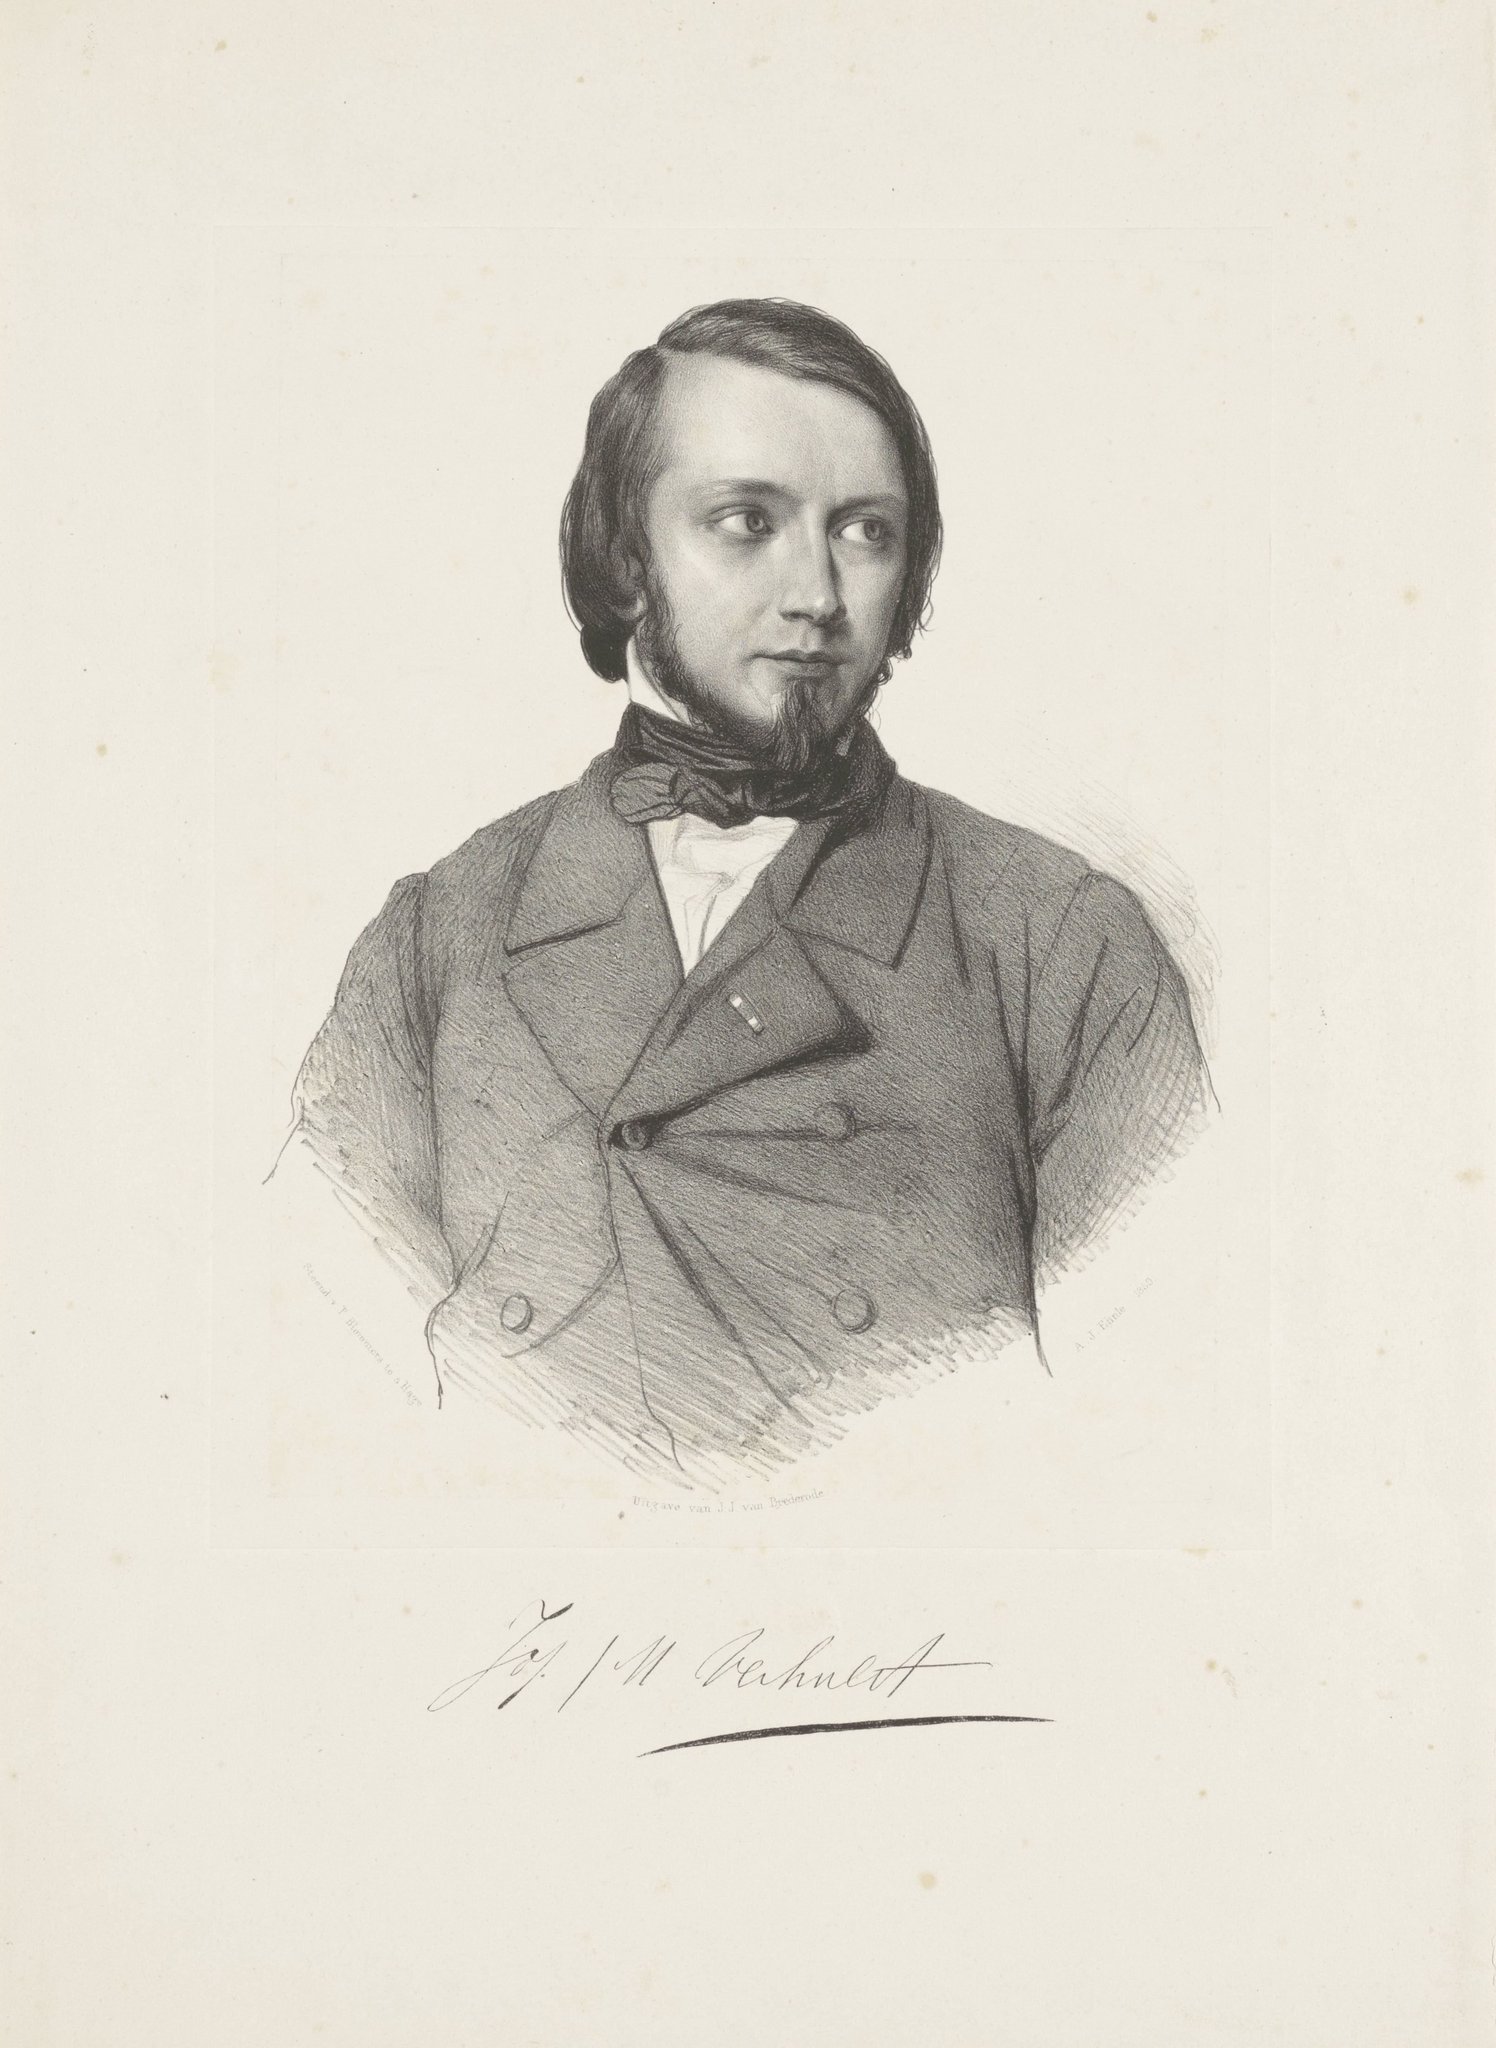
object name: print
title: Portret van Johannes Josephus Herman Verhulst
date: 1847-1883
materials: paper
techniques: lithograph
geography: the hague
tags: the hague, johannes verhulst, knighthood order, historical persons (+ (full) bust portrait)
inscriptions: collector's mark: Lugt 2760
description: De geportretteerde draagt een ridderorde op de revers van zijn jas en hij kijkt naar rechts. Onder het portret zijn signatuur.